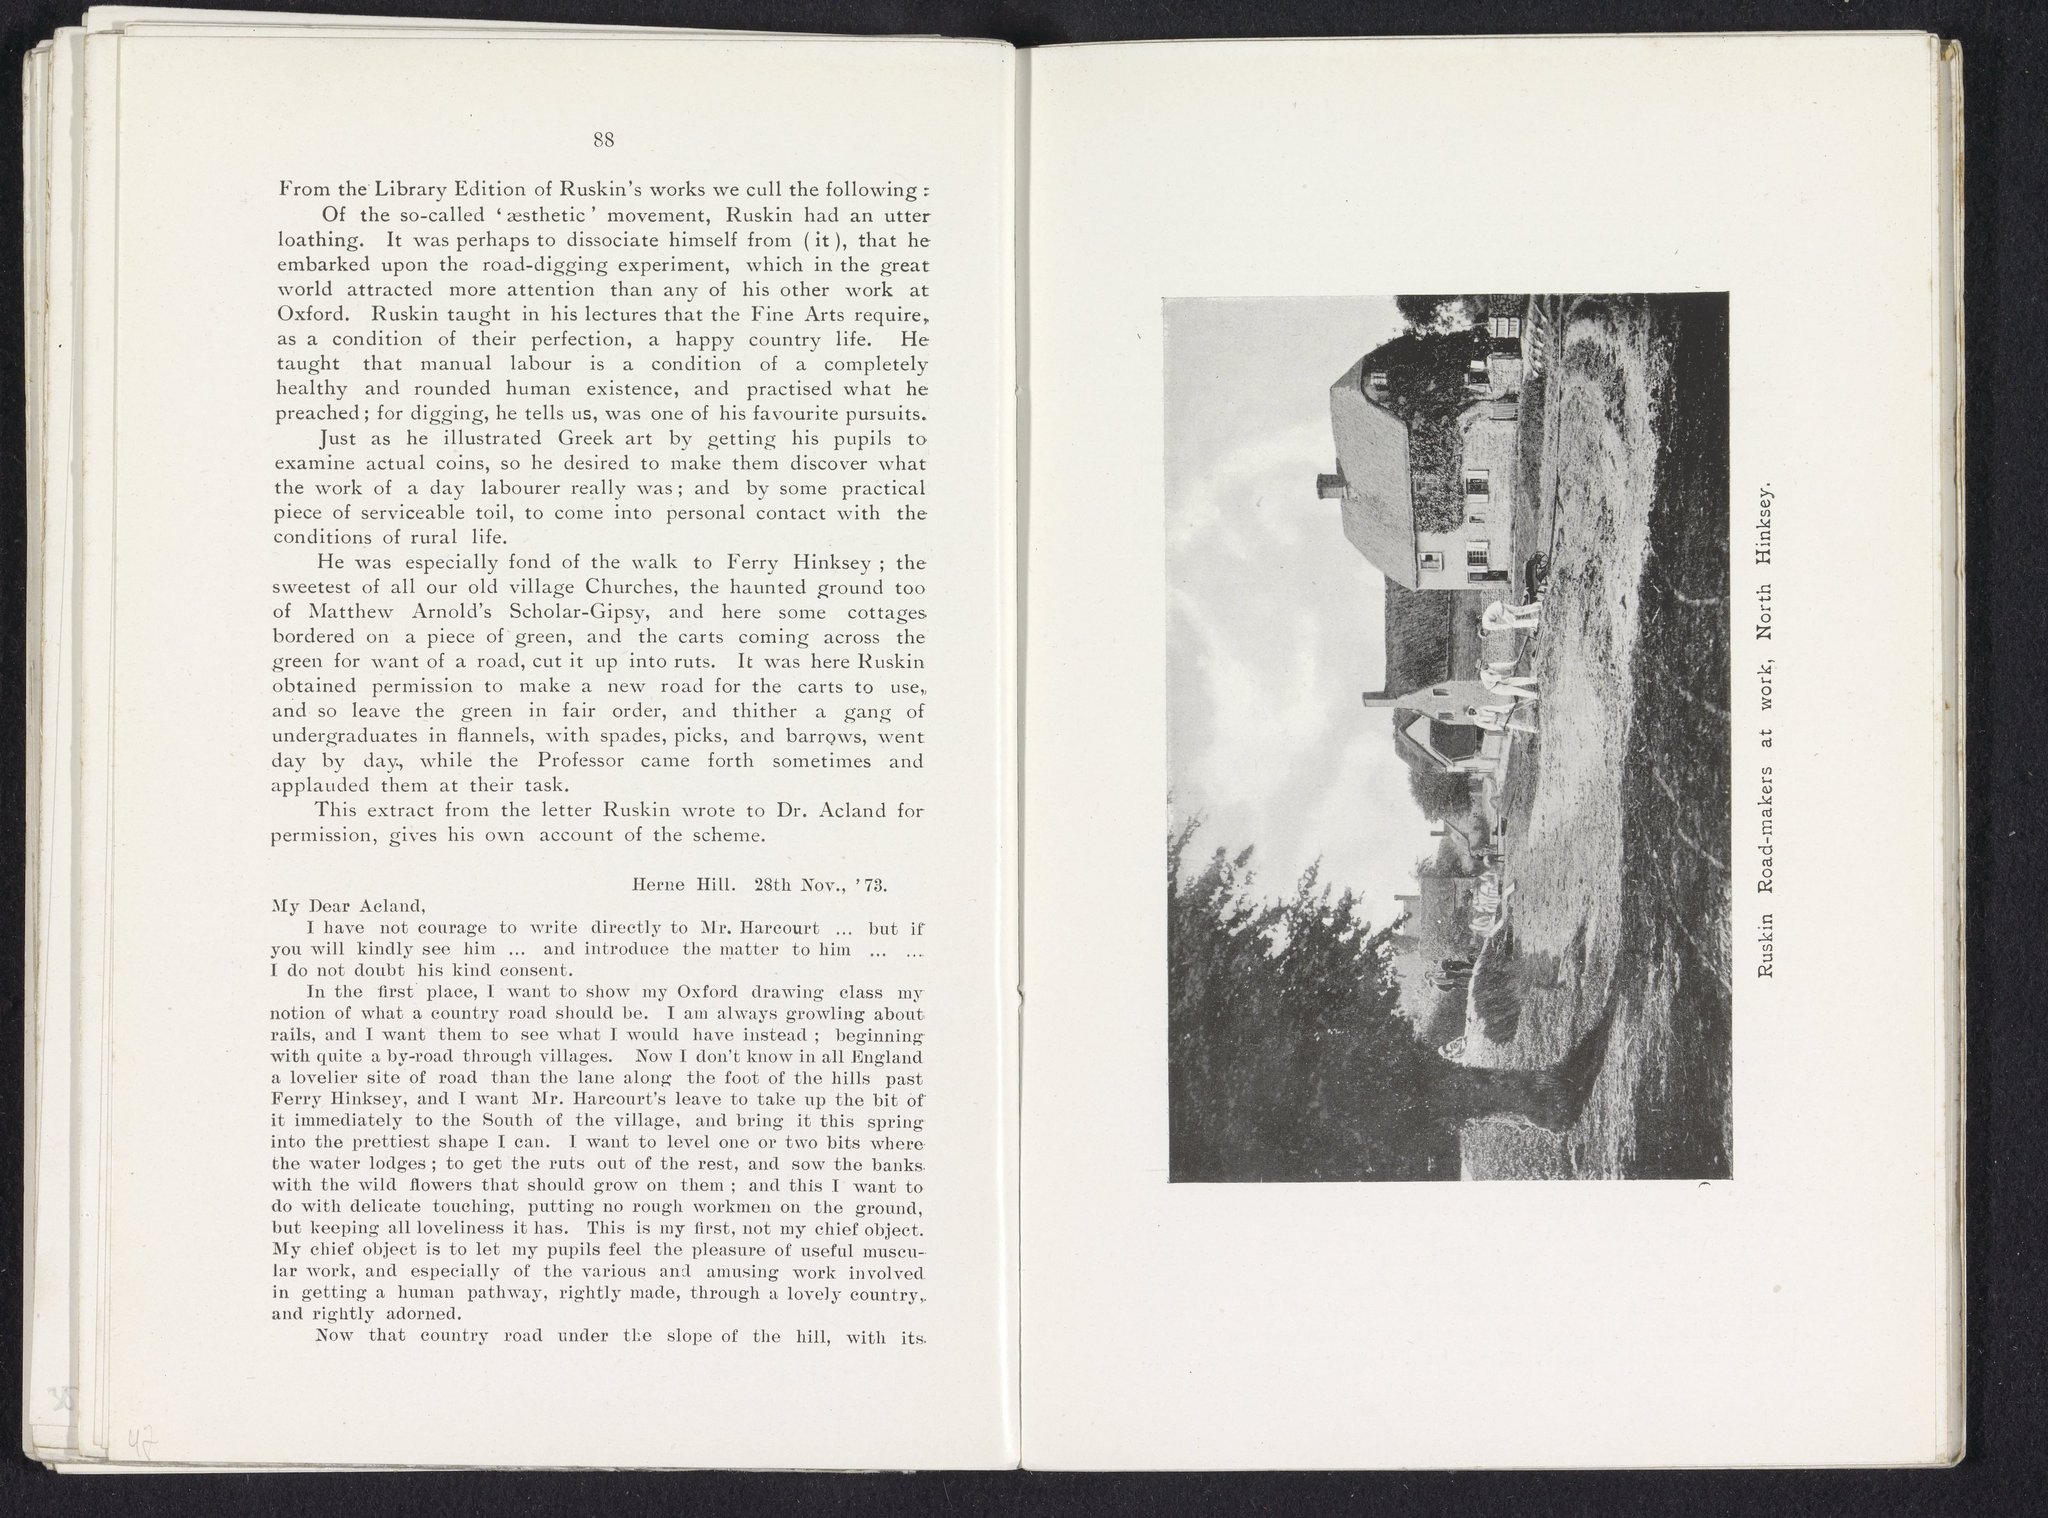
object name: photomechanical print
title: Ruskin road-makers at North Hinksey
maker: henry w. taunt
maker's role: fotograaf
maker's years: 1842-1922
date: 1806-1874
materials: paper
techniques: autotype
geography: north hinksey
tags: housing, public road in village